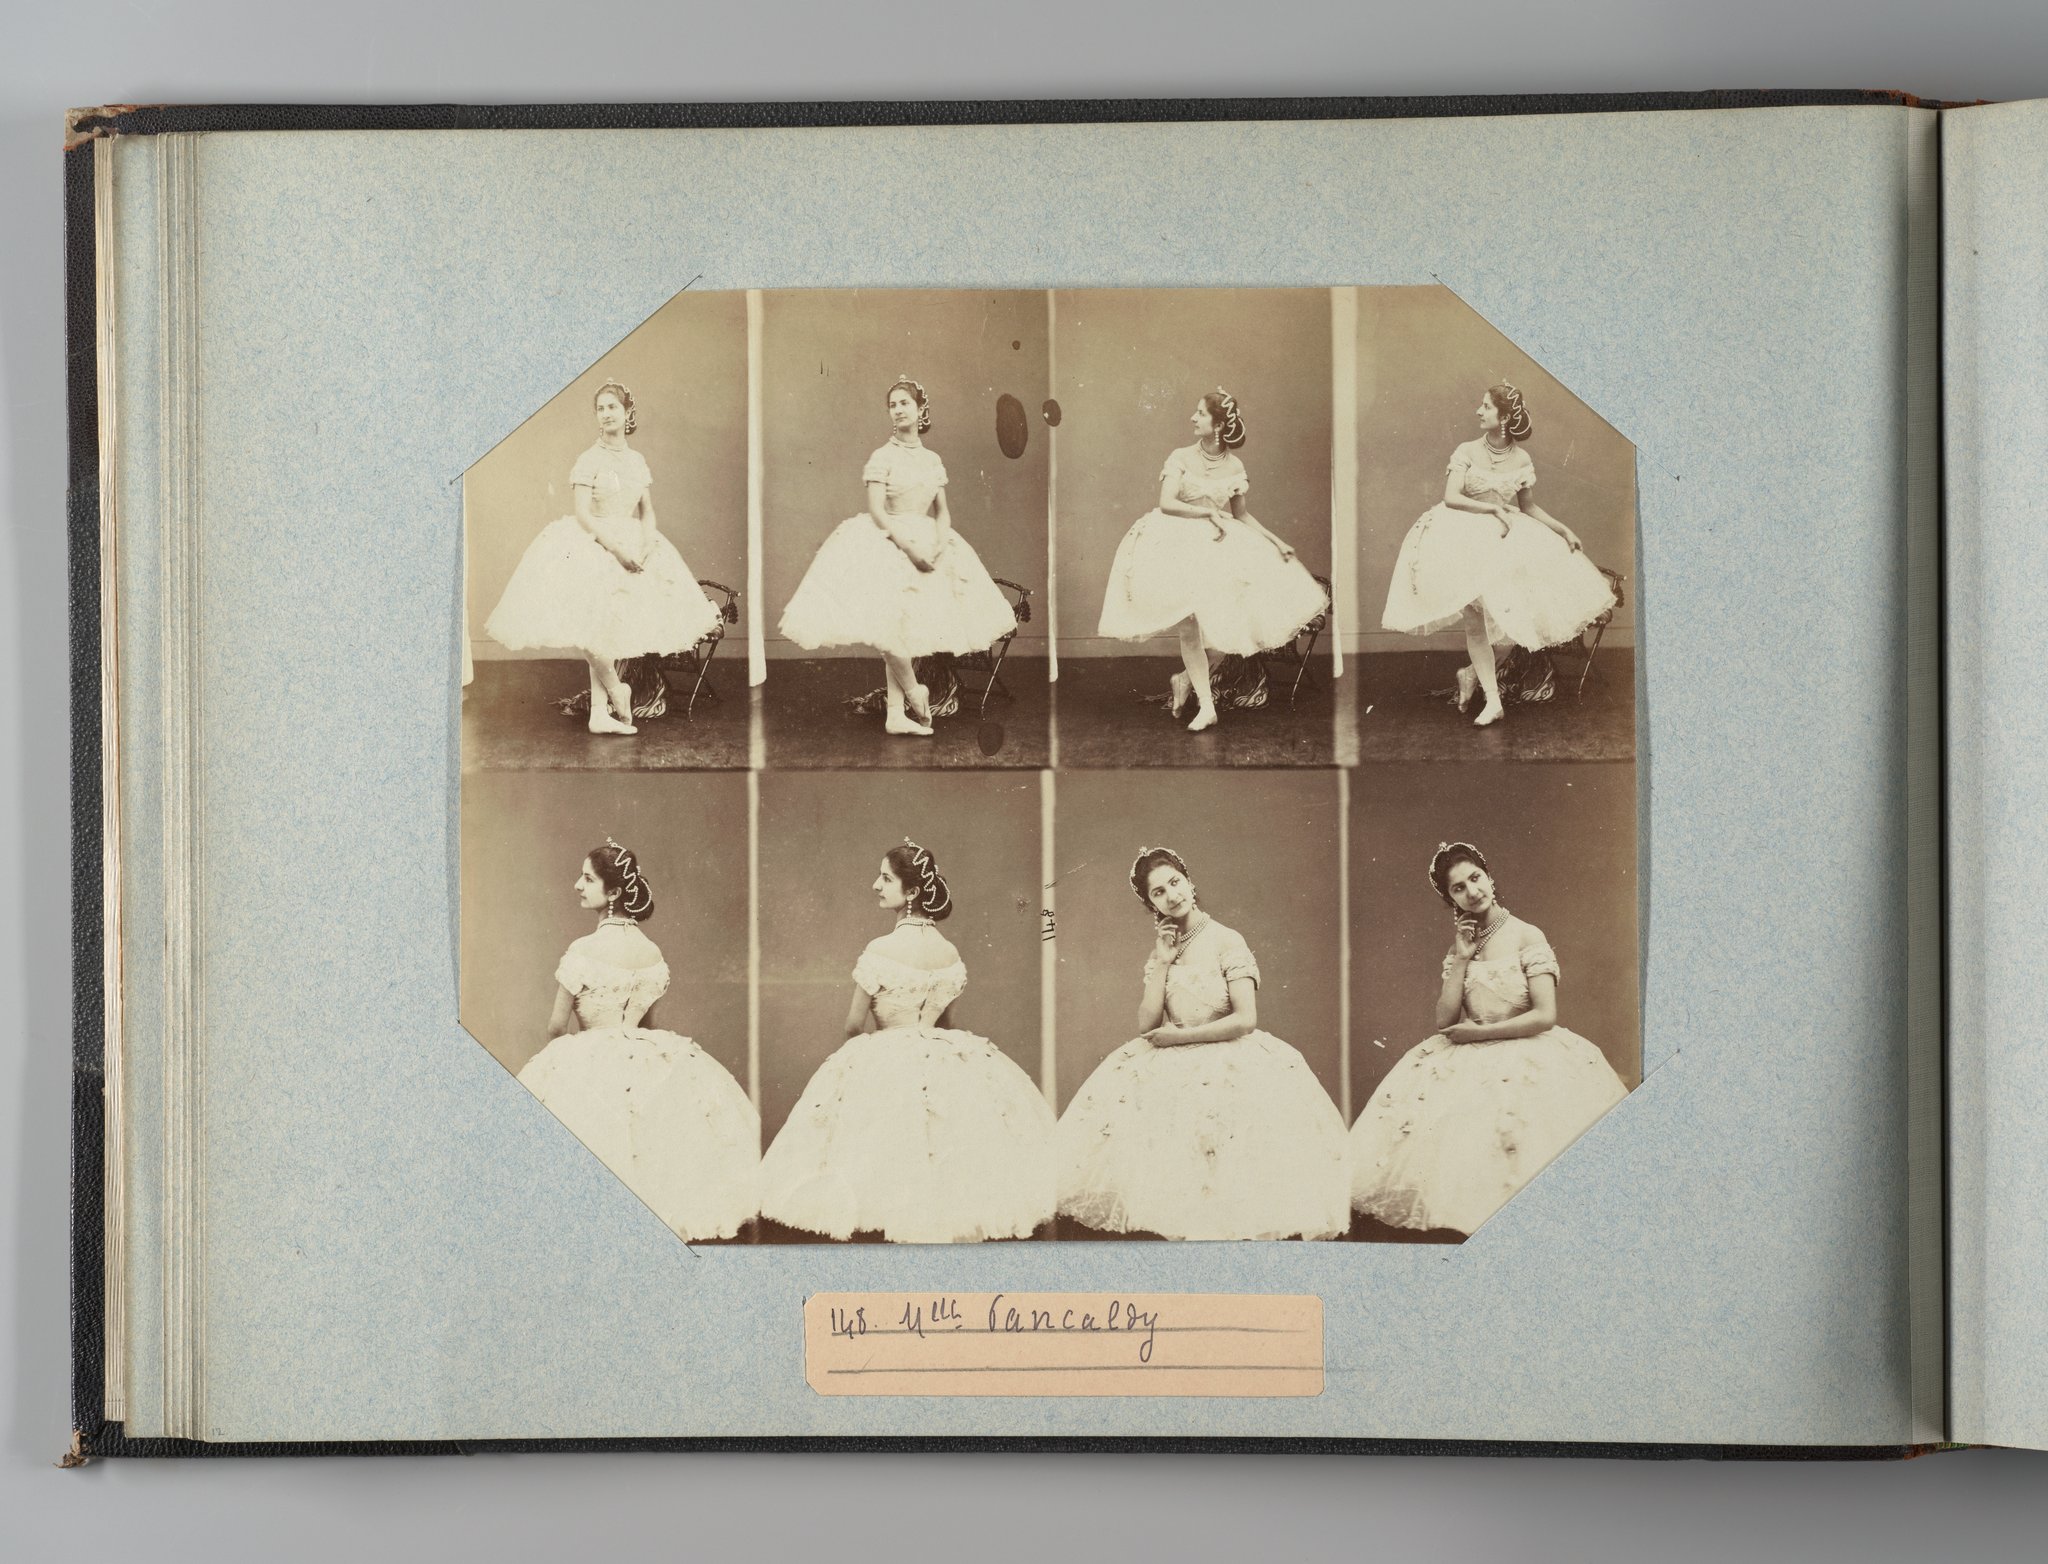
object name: photograph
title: Mlle Pancaldy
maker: andré-adolphe-eugène disdéri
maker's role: artist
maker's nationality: french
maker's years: 1819-1889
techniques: albumen silver print, glass negative